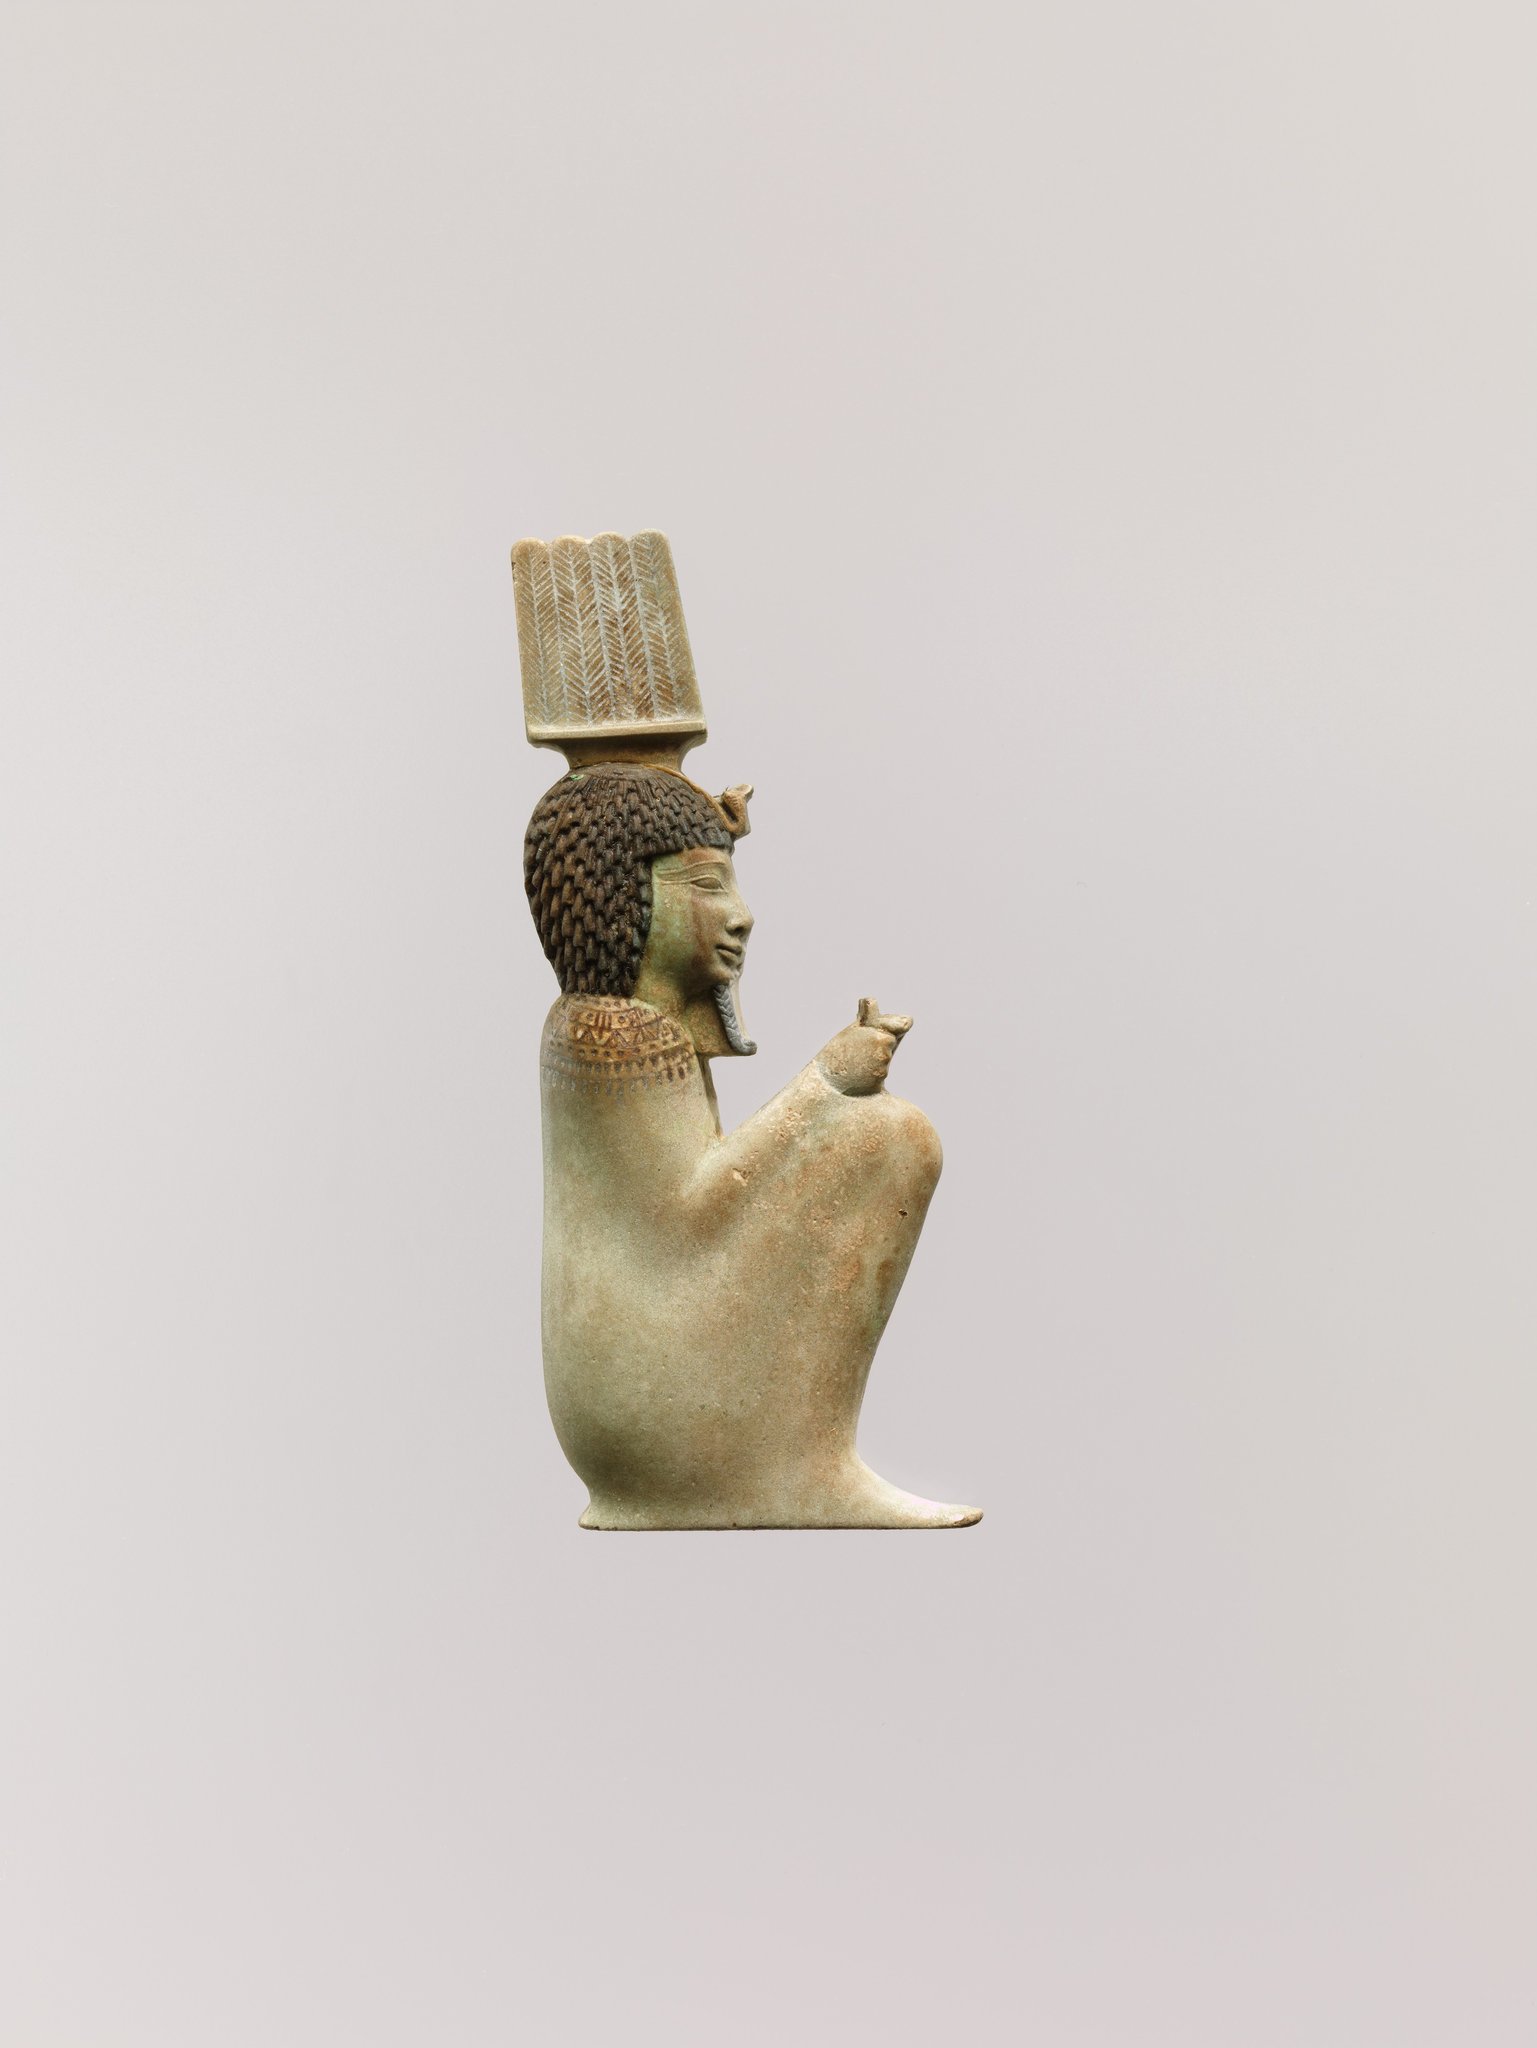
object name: inlay, anhur, facing right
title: Inlay of the squatting god Anhur (Onuris)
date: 400-301 BCE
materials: faience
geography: middle egypt